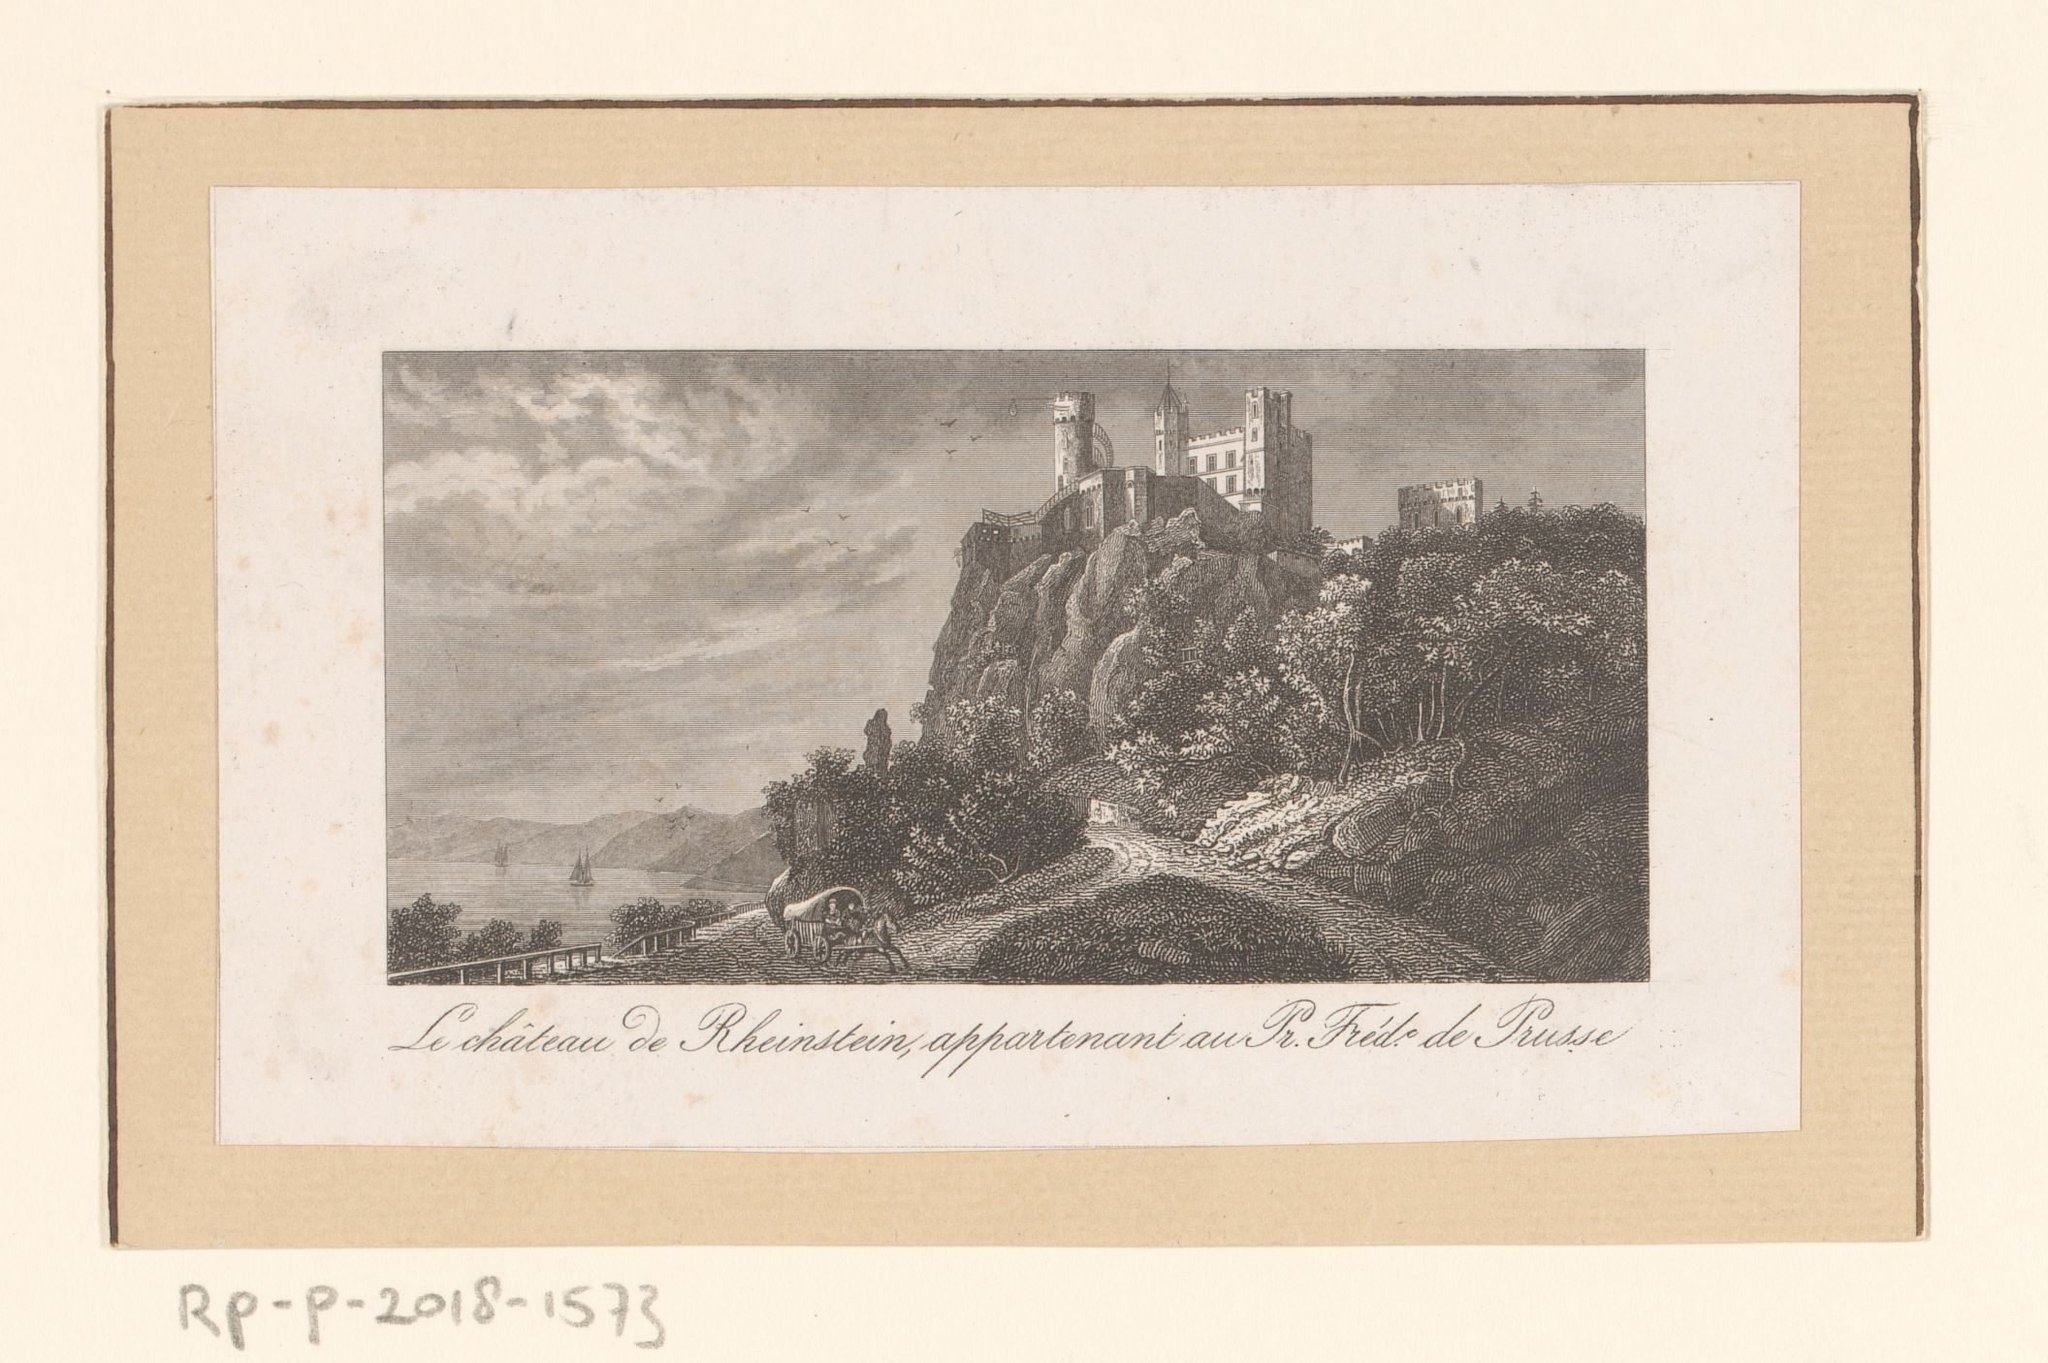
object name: print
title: La chateau de Rheinstein, appartenant au Pr. Fréd. de Prusse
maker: Anonymous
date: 1800-1899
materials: paper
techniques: engraving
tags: castle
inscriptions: collector's mark: Lugt 2228